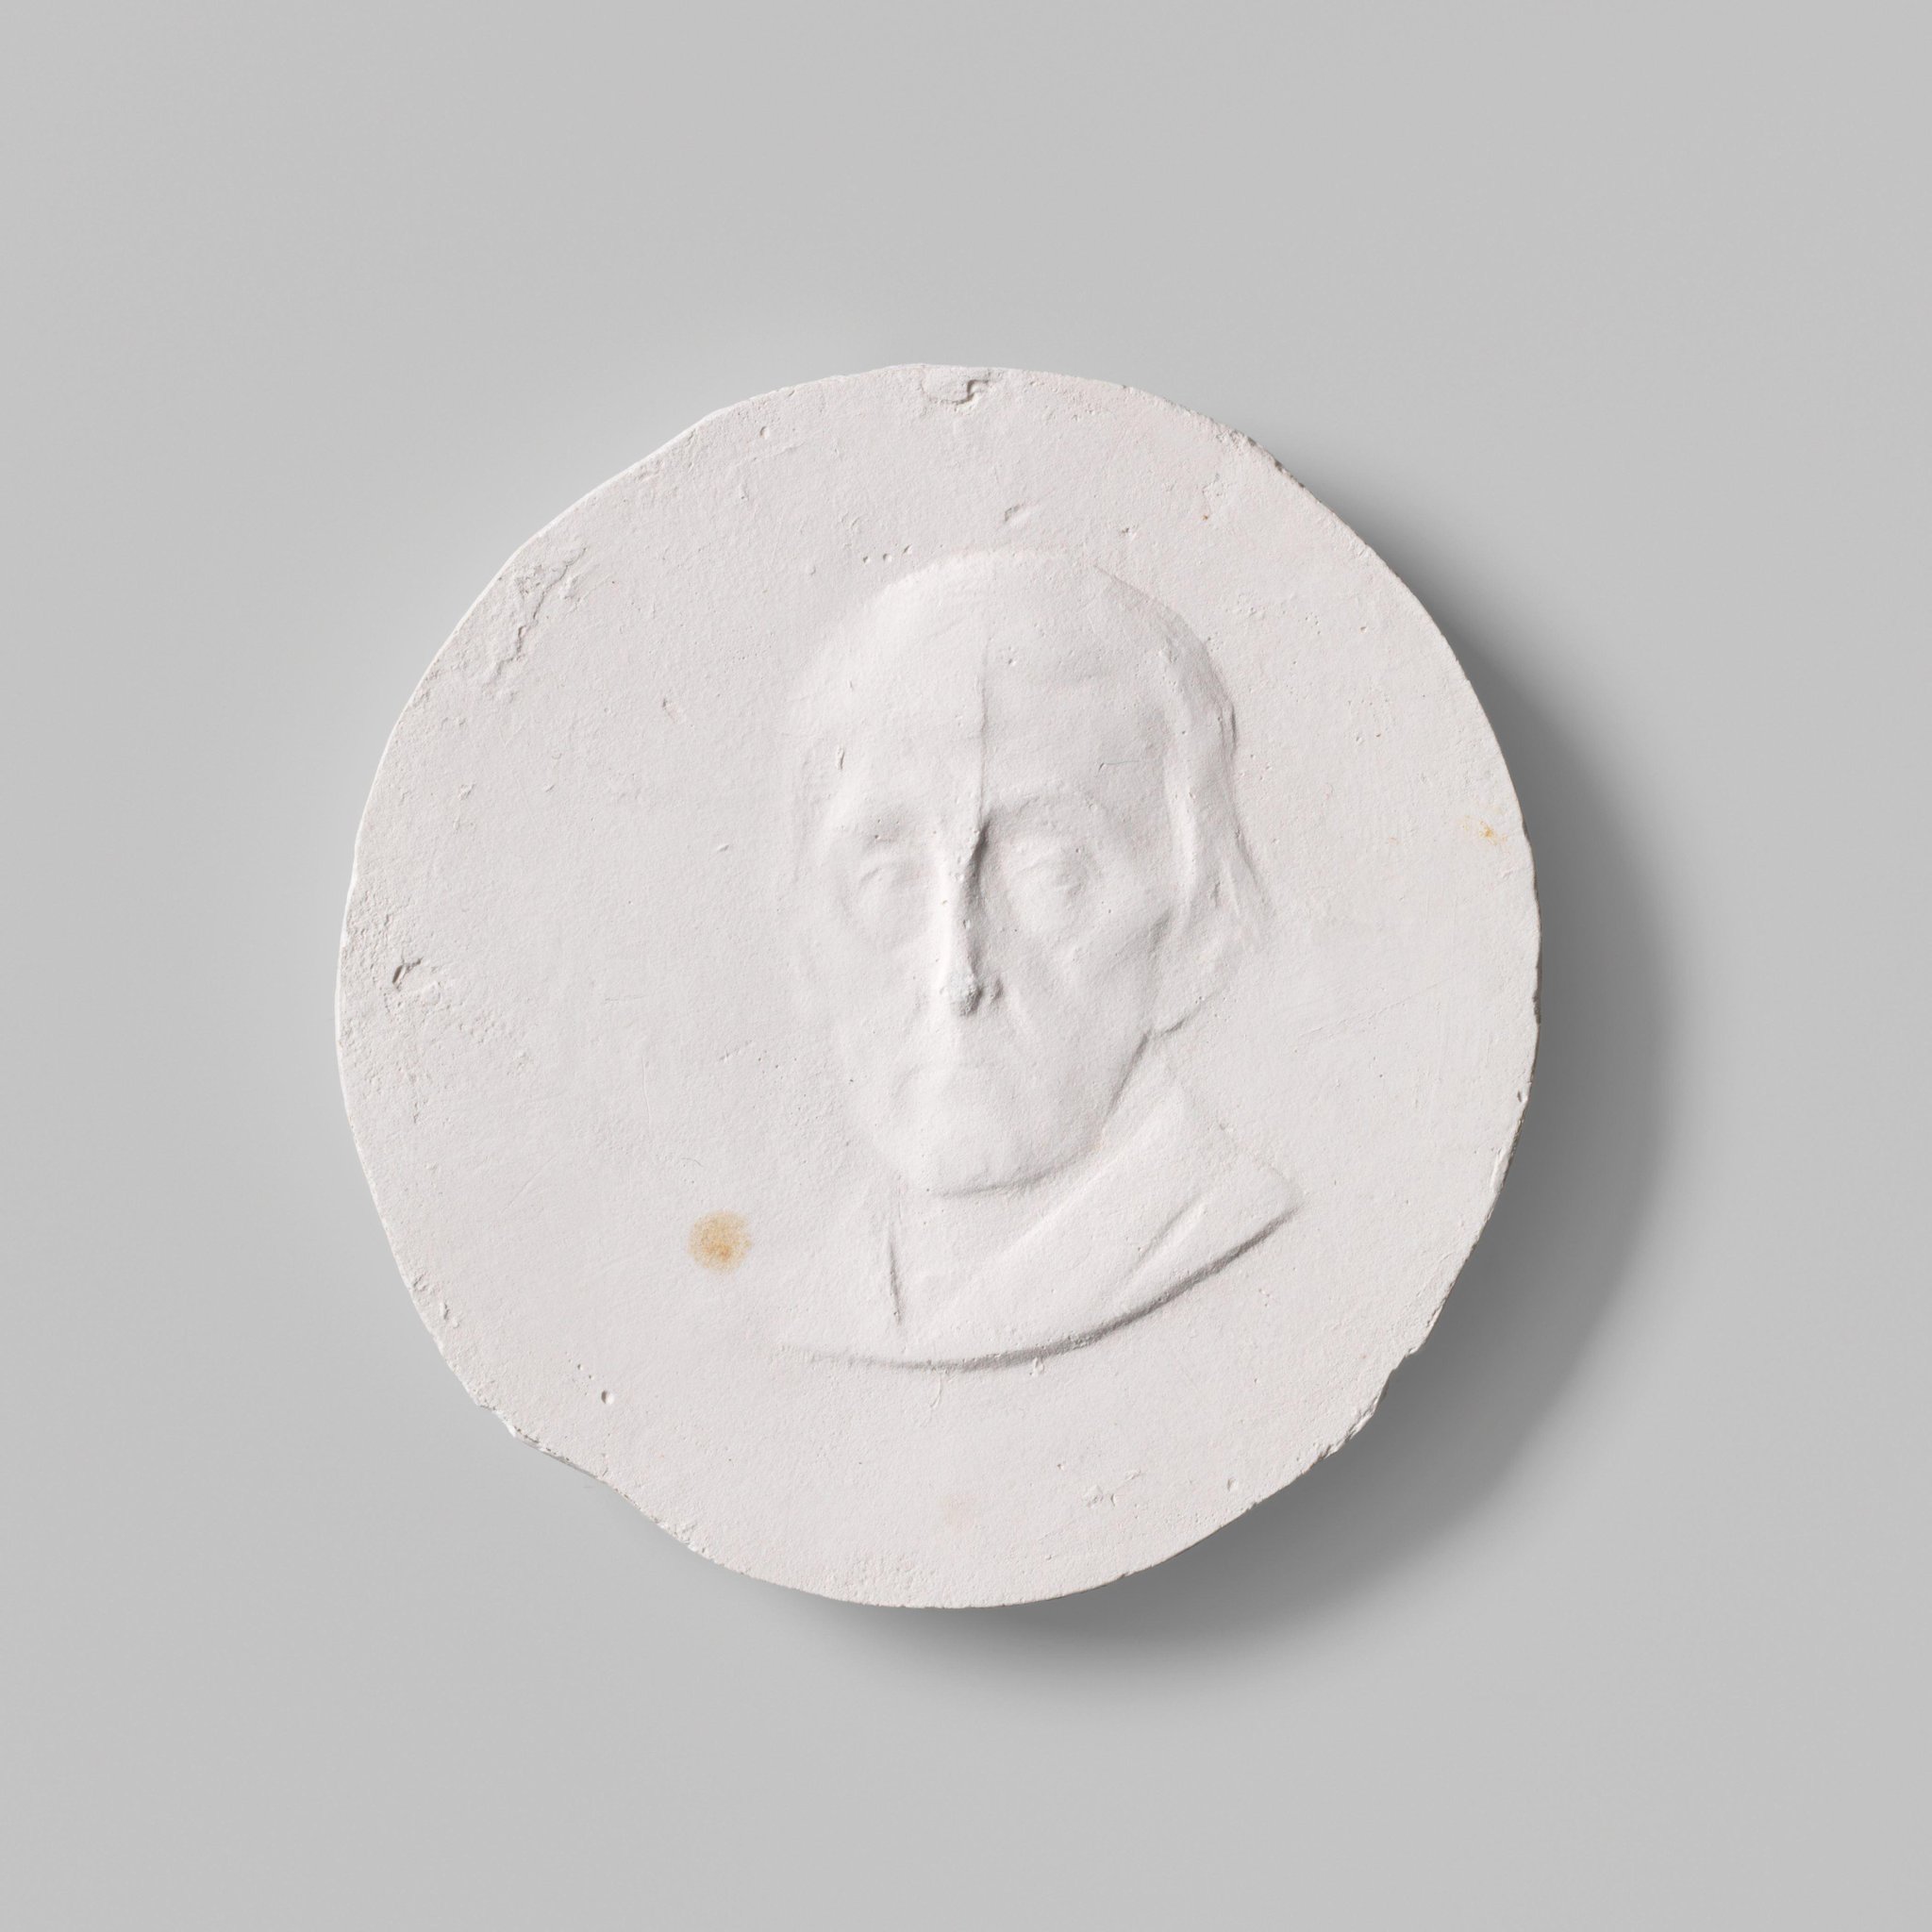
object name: medal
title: Ontwerp voor een penning met mansportret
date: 1800-1972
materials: gypsum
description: Ontwerp van gips voor een penning met mansportret.